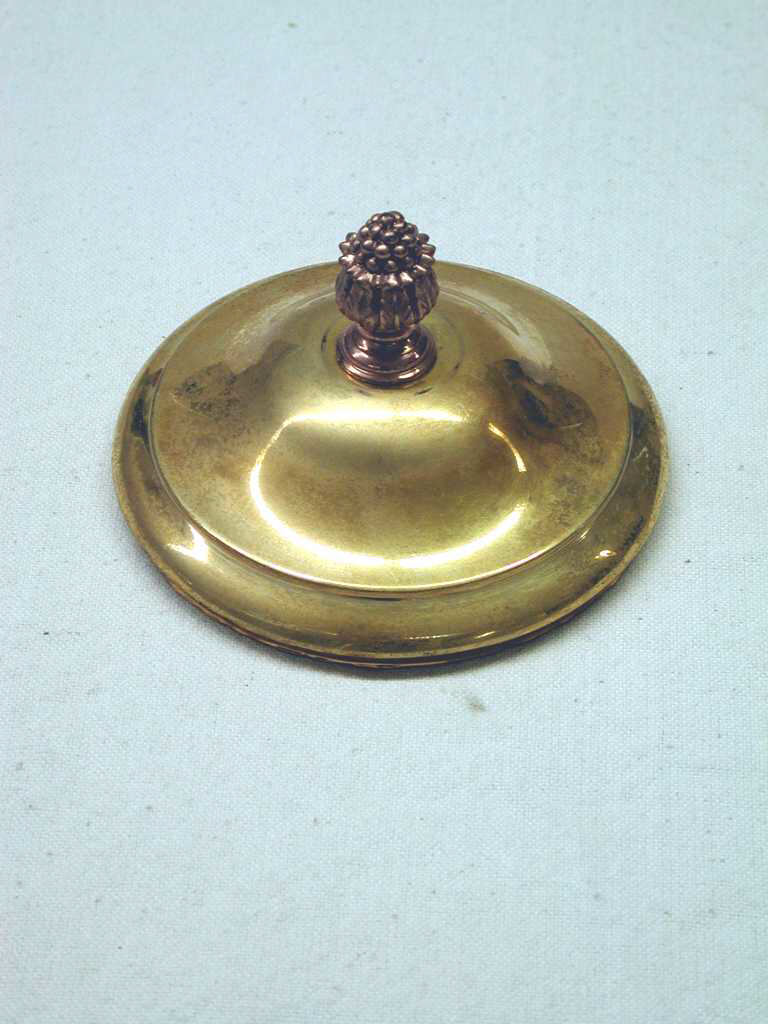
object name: cover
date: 1801-1900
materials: metal